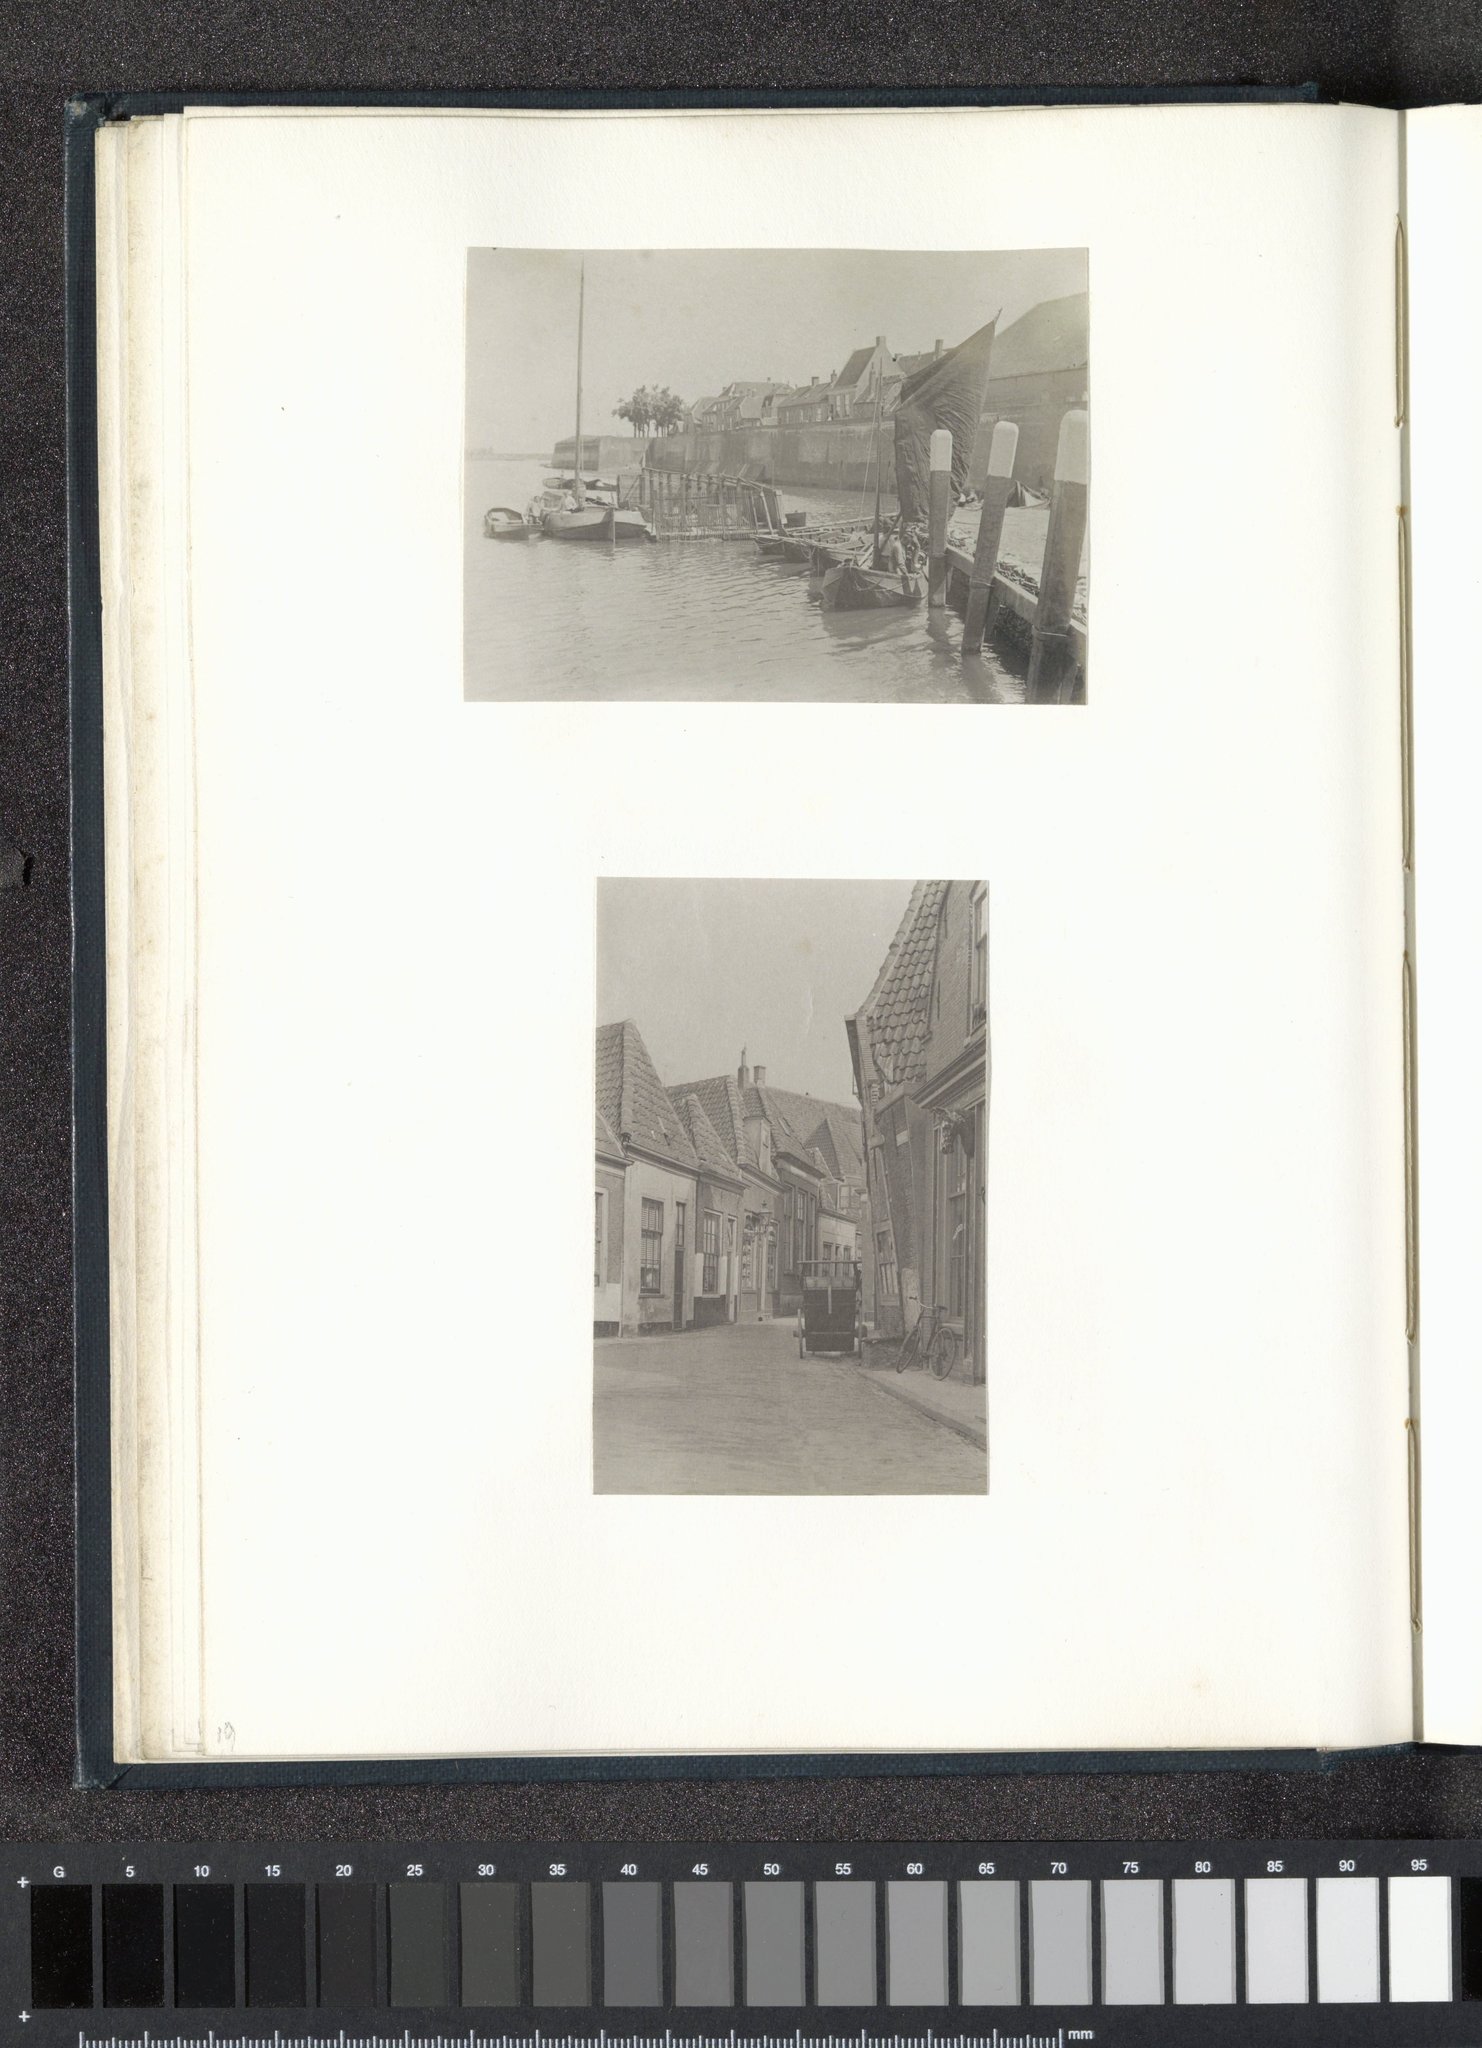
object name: photograph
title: Gezicht op de Schoolsteeg in Hoorn, gezien vanaf het Gerritsland richting de Grote Oost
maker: george hidderley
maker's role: fotograaf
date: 1900-1910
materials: paper, photographic support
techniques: gelatin silver print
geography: hoorn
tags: hand-cart, bicycle, the usual house or row of houses, street (+ city(-scape) with figures, staffage), hoorn (north holland)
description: Onderdeel van fotoalbum met opnames van Volendam, Dordrecht, Gorinchem en Woudrichem.